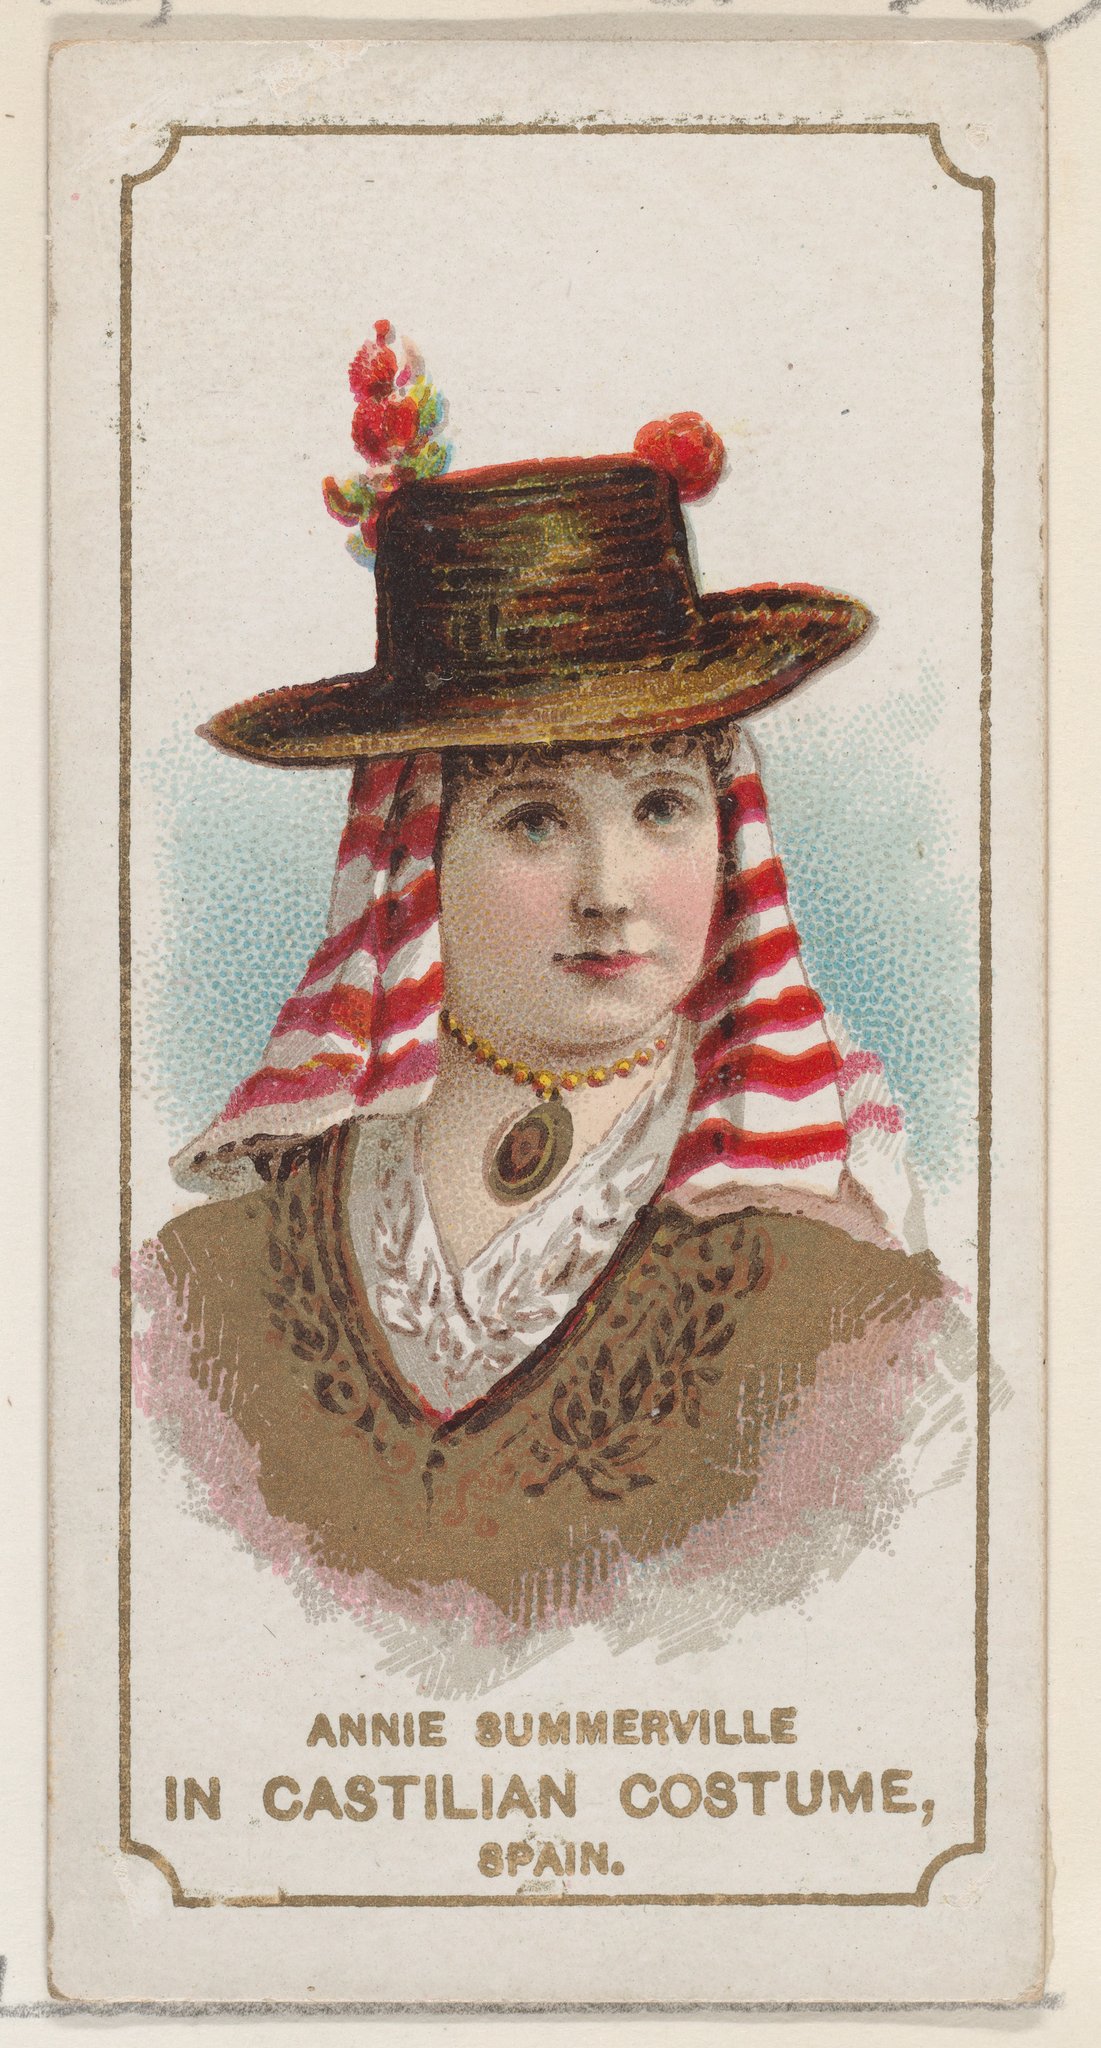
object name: print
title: Annie Summerville in Castilian Costume of Spain, from the set Actors and Actresses, First Series (N70) for Duke brand cigarettes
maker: w. duke, sons & co.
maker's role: publisher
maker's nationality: american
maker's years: 1870-1920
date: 1888-1889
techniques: color lithograph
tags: women,actresses